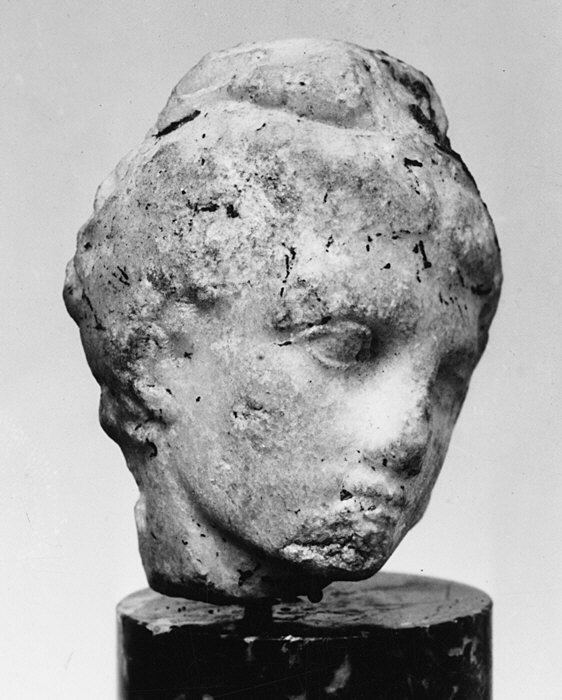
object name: head of a youth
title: Marble head of a youth from a relief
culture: greek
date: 400-301 BCE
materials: marble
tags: heads,boys